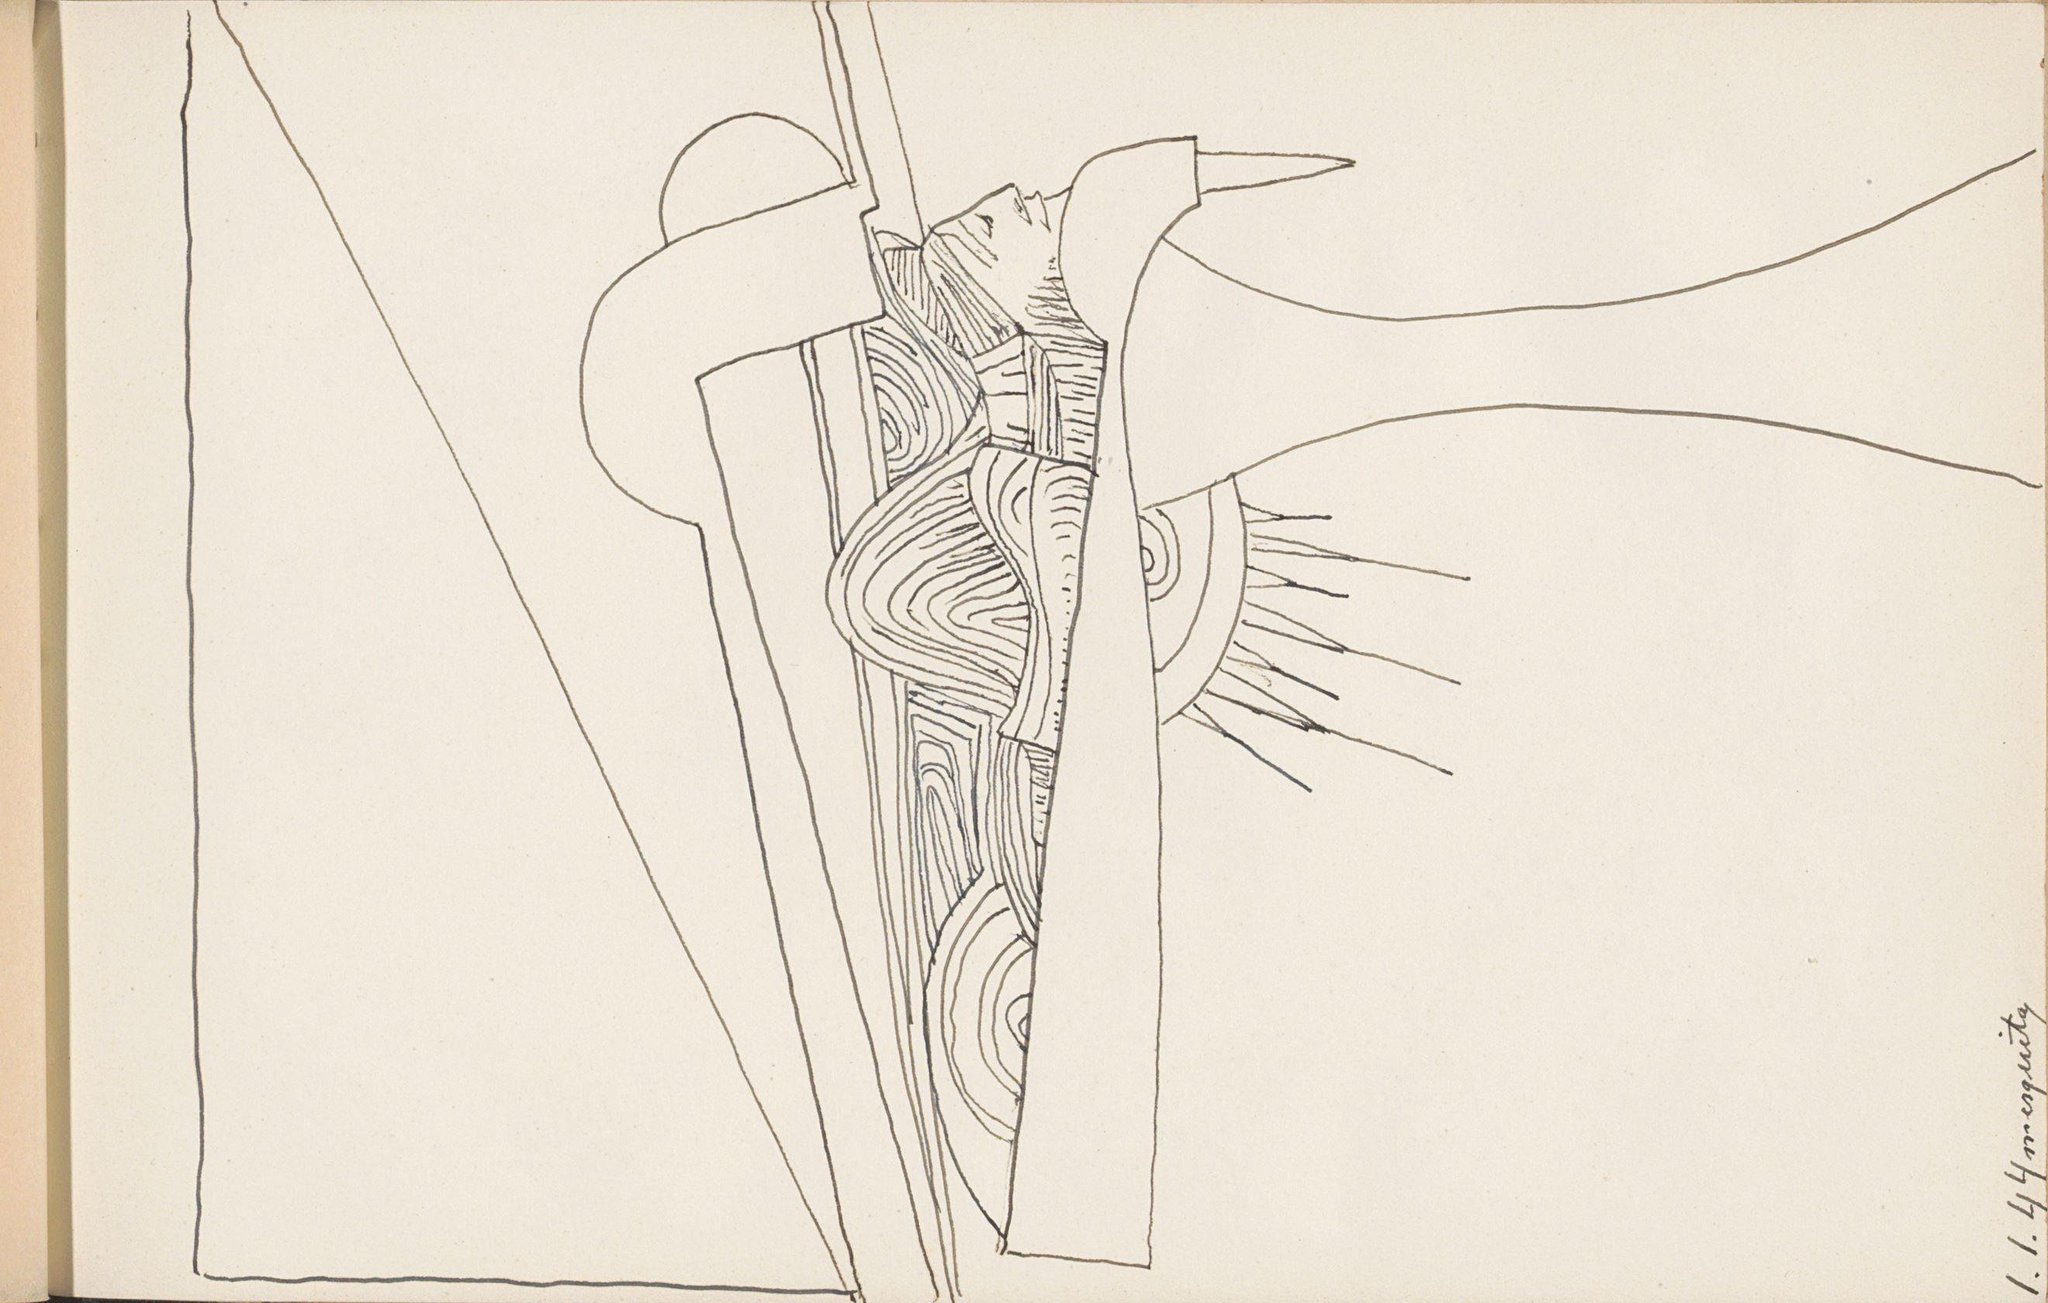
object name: sketchbook leaf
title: Fantasiefiguur temidden van een driehoek en andere vormen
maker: samuel jessurun de mesquita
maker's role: draughtsman, print maker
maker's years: 1868-1944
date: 1944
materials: ink, paper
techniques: pen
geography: amsterdam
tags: anthropomorphic beings with parts missing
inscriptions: signature and date: ‘1.1.44 mesquita’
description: Blad 18 recto uit een schetsboek met 18 bladen.